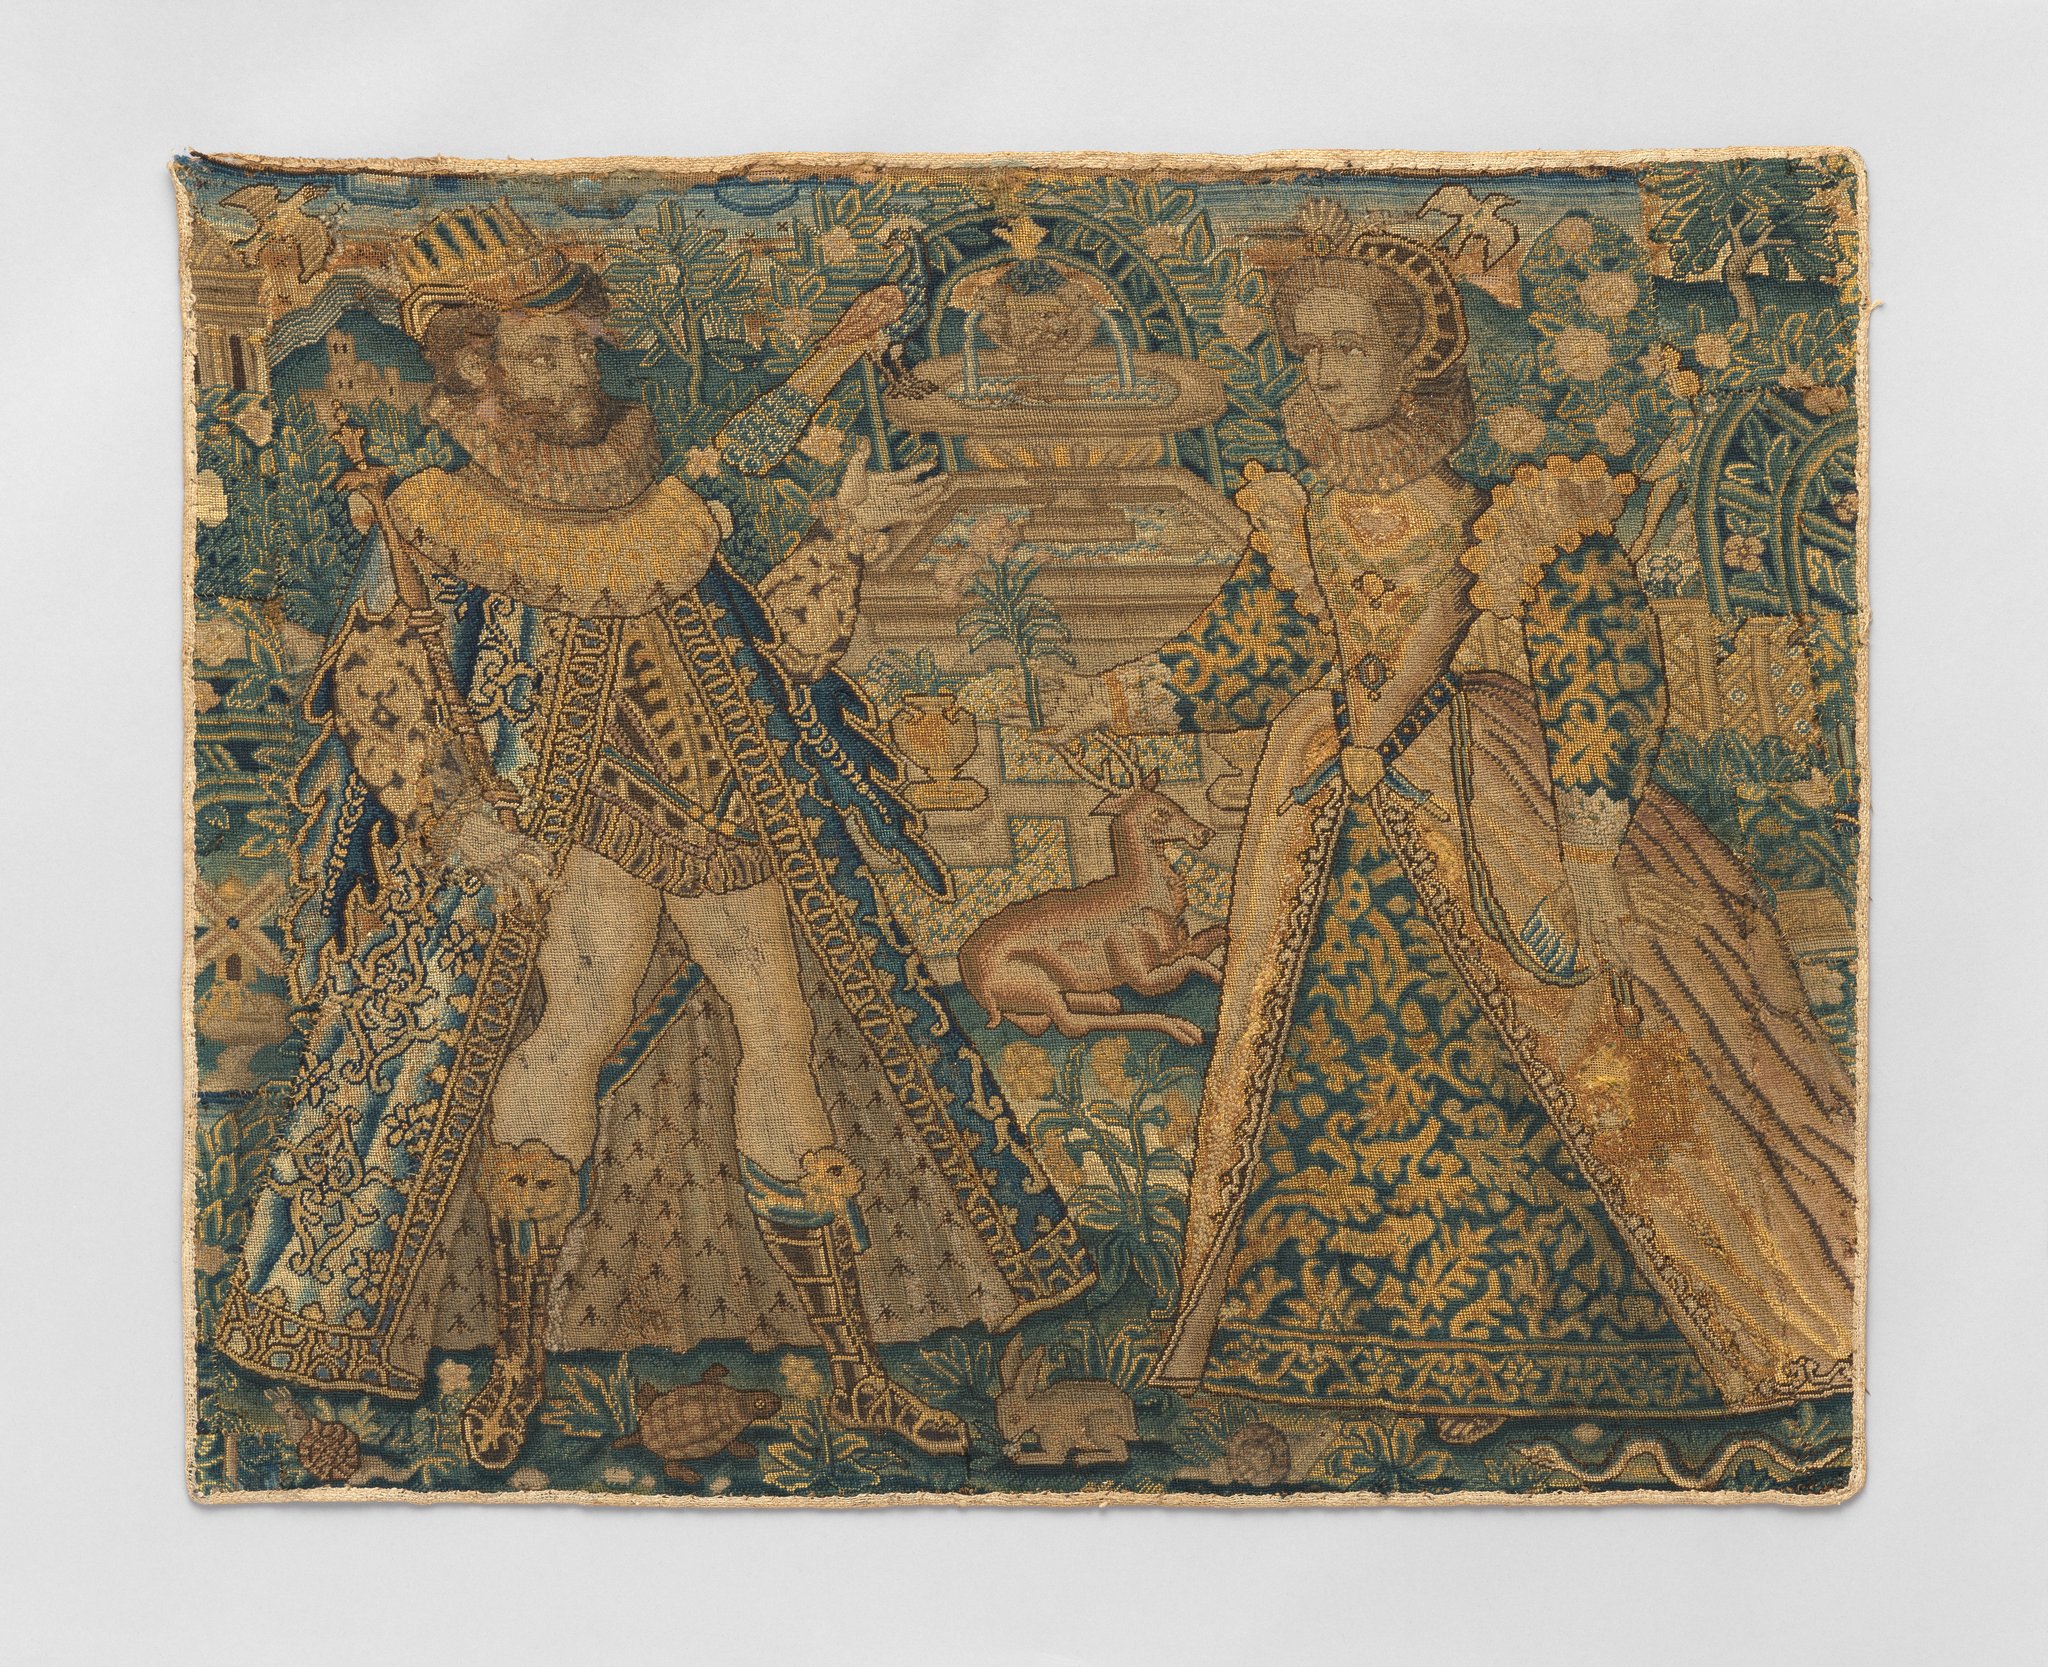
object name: panel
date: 1601-1633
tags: men,women,peacocks,deer,rabbits,snakes,turtles